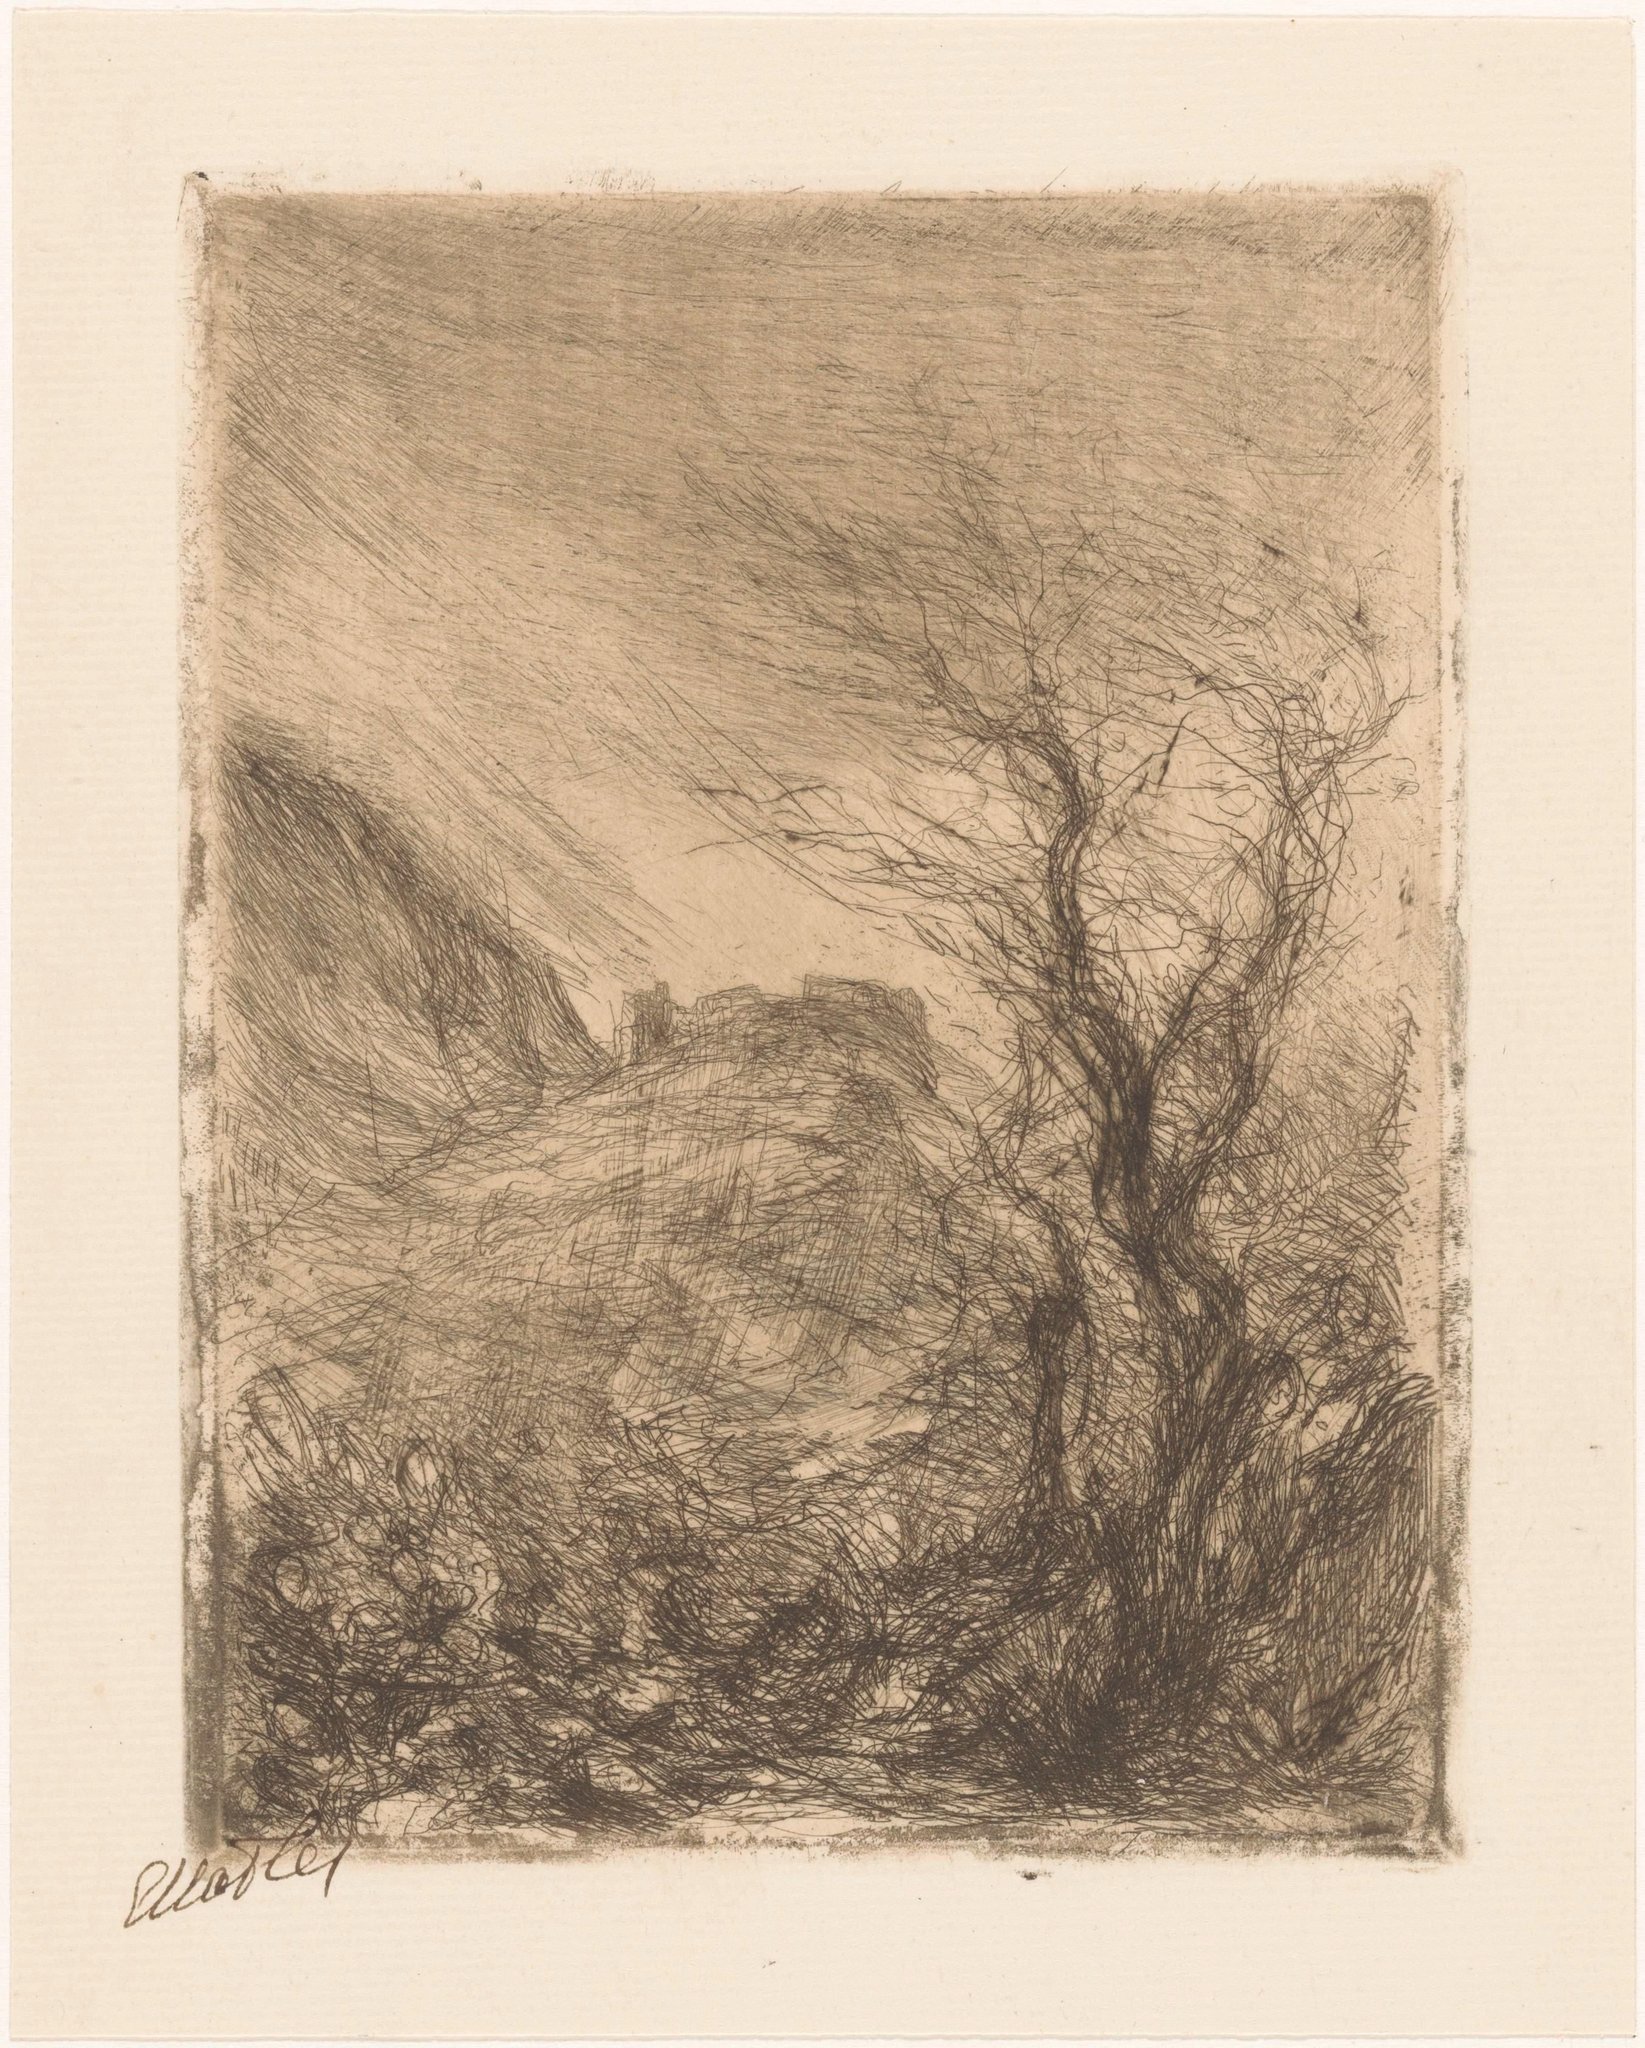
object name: print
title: Capri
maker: etha fles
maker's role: print maker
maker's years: 1857-1948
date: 1867-1910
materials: paper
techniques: drypoint, intaglio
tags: trees, (high) hill, capri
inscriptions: collector's mark: Lugt 2228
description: Een boom in een heuvellandschap op het Italiaanse eiland Capri in de Golf van Napels.